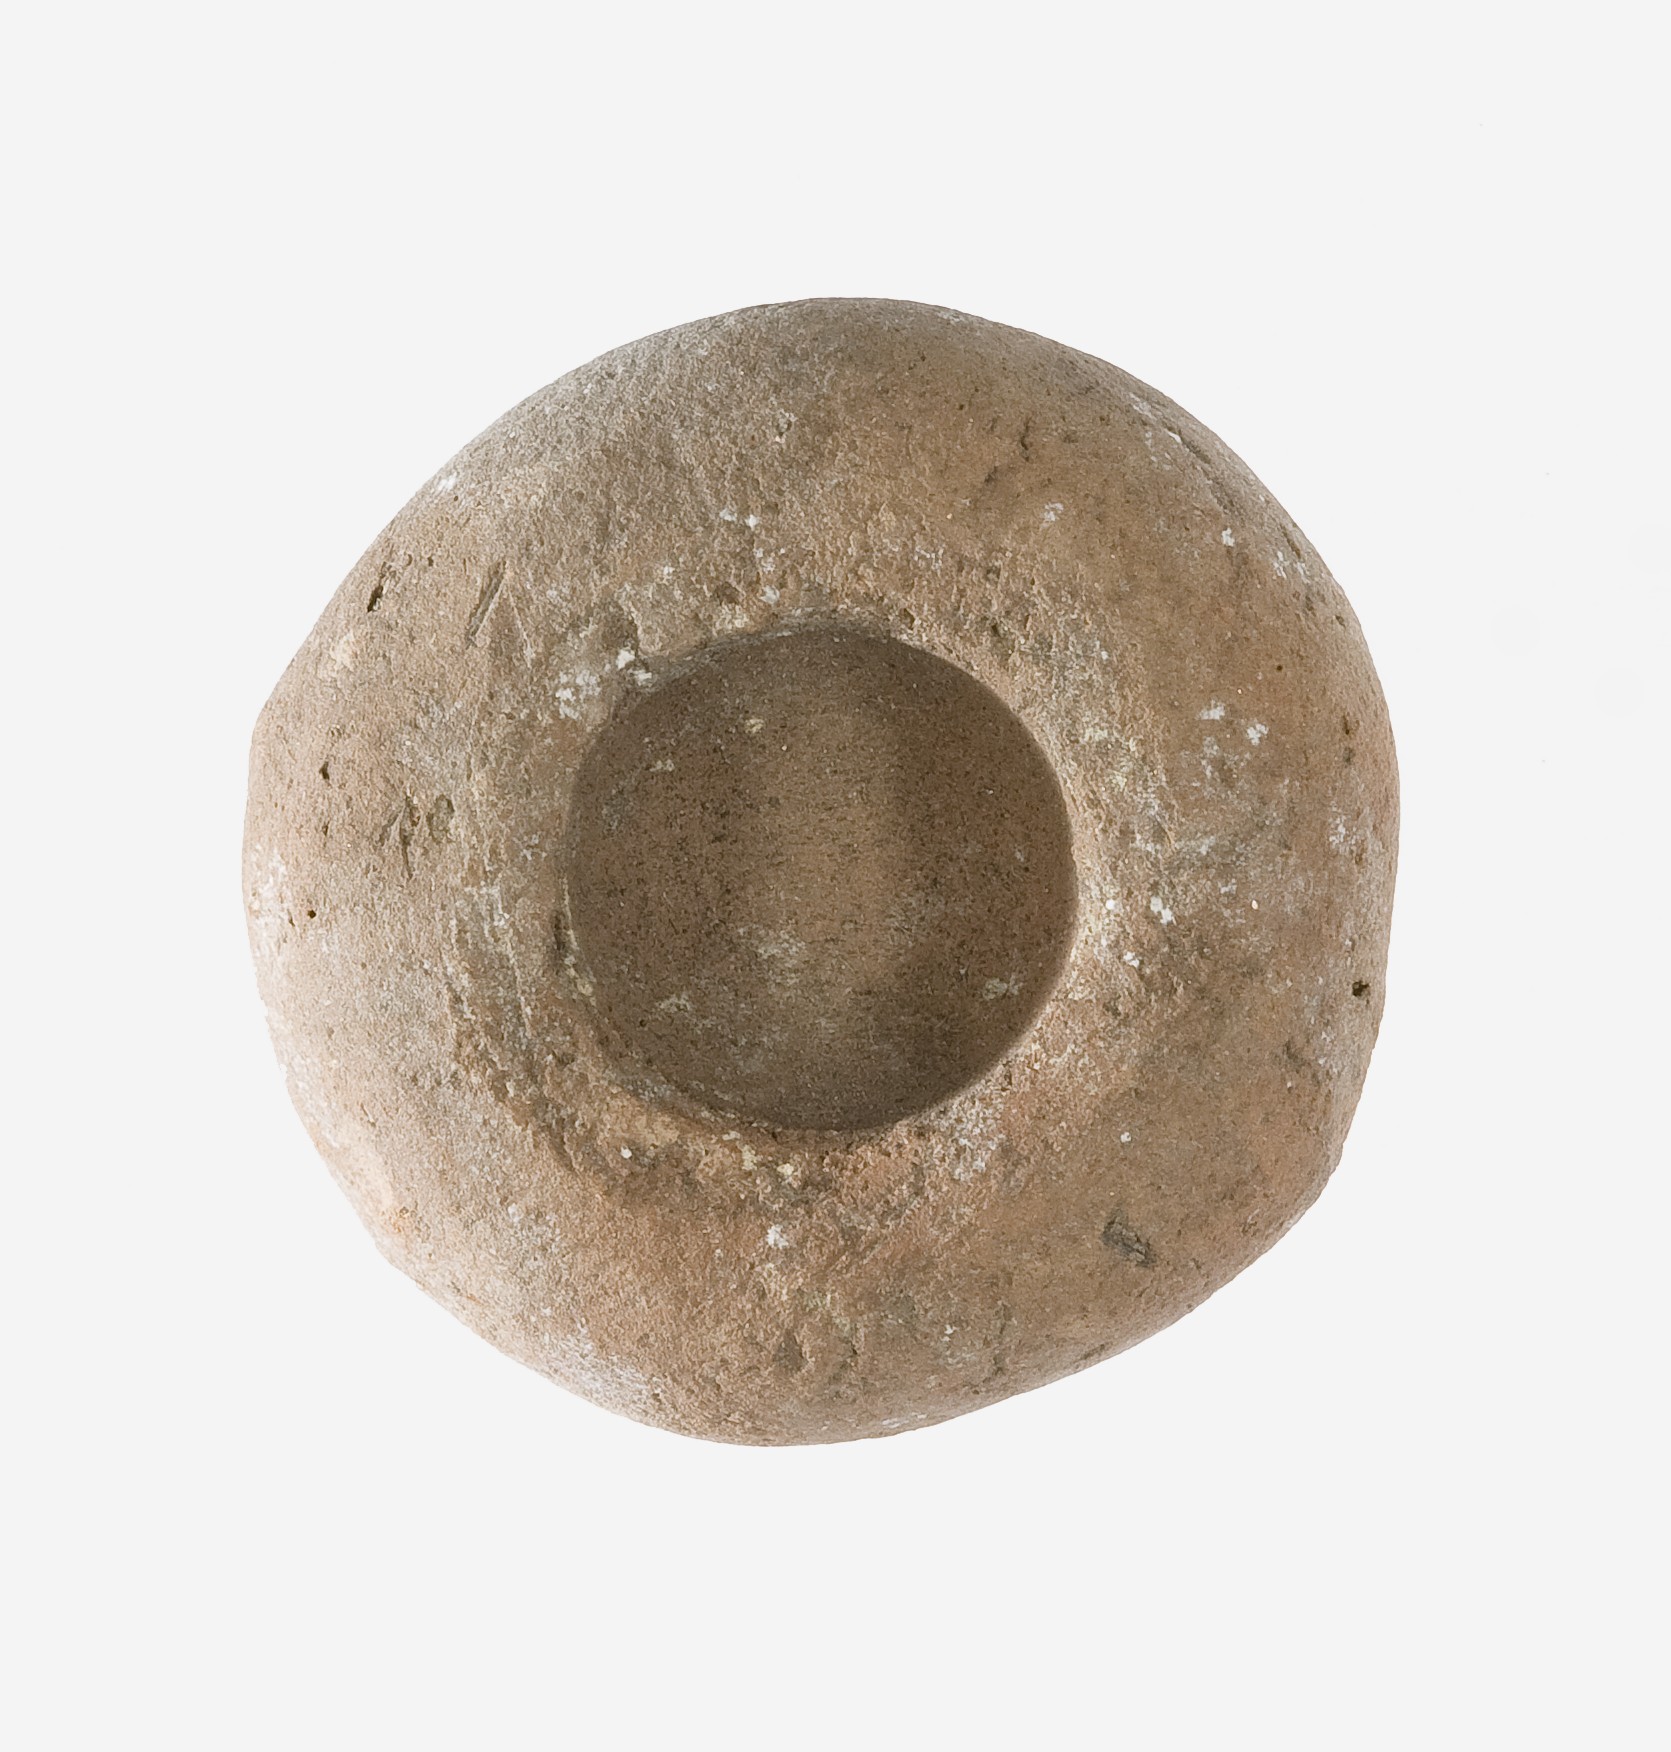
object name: mold, hemisphere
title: Mold for a Hemispherical Boss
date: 1390-1352 BCE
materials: pottery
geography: egypt